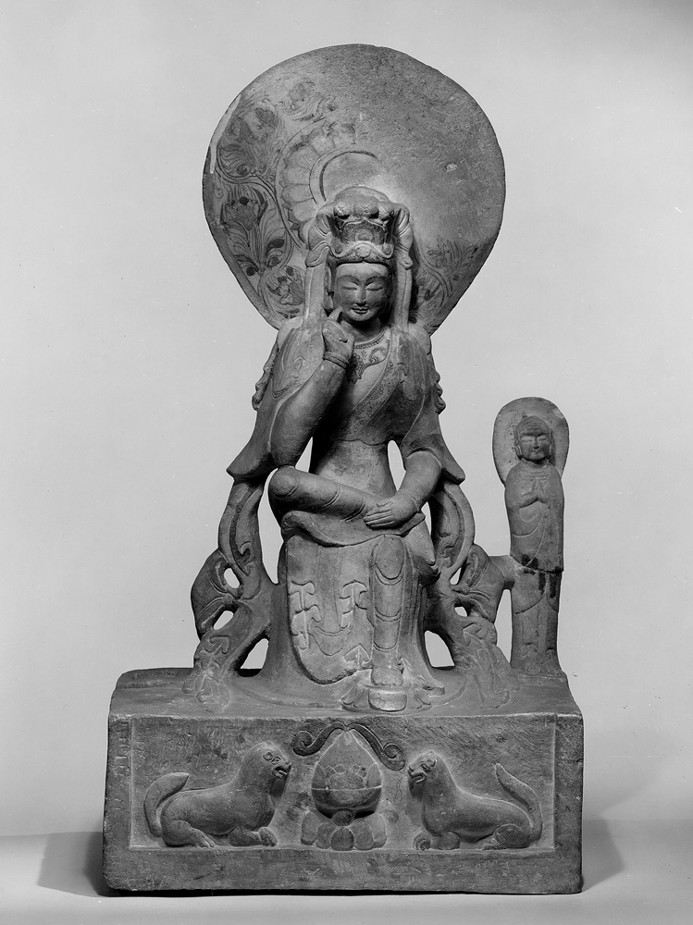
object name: figure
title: Maitreya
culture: chinese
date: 599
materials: marble, pigment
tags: buddhism,maitreya